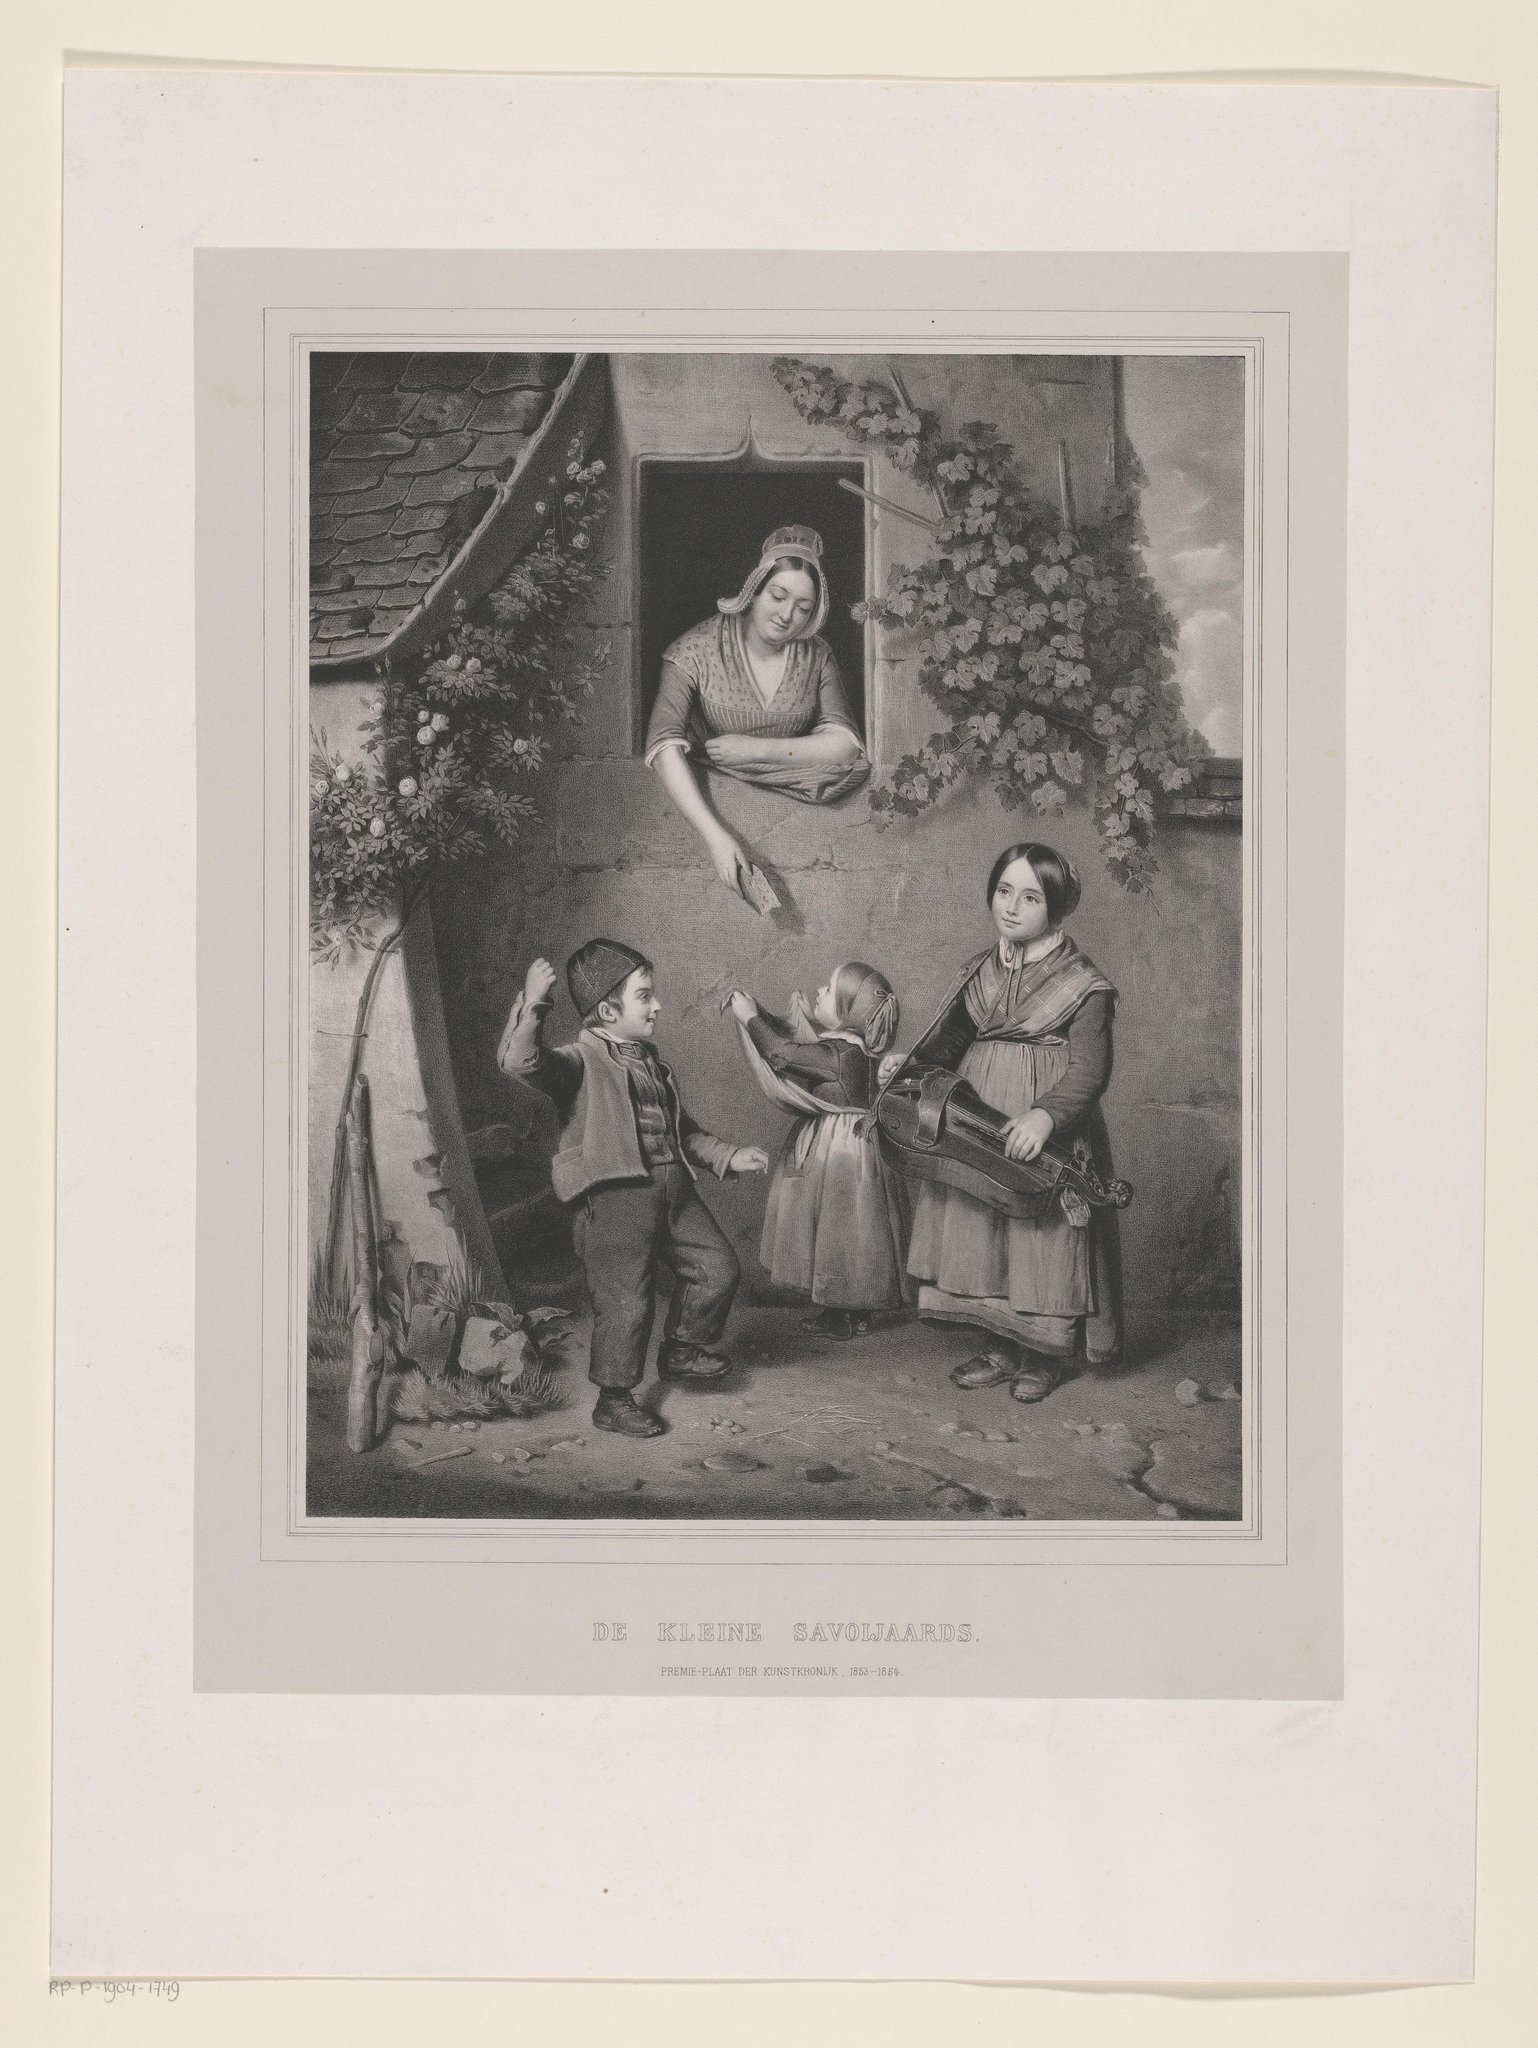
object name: print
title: Drie kinderen bij een vrouw leunend uit een raam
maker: Anonymous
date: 1853-1854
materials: paper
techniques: lithograph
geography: netherlands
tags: child, children playing musical instruments, beggar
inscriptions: collector's mark: Lugt 2228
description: Drie Savojaardse kinderen staan voor een huis waarin een vrouw uit een raam leunt. De jongen danst op de muziek die het meisje rechts op de draailier speelt. Het meisje in het midden krijgt van de vrouw een stuk kaas in de schort geworpen. Premieplaat bij Kunstkronijk 1853-54.